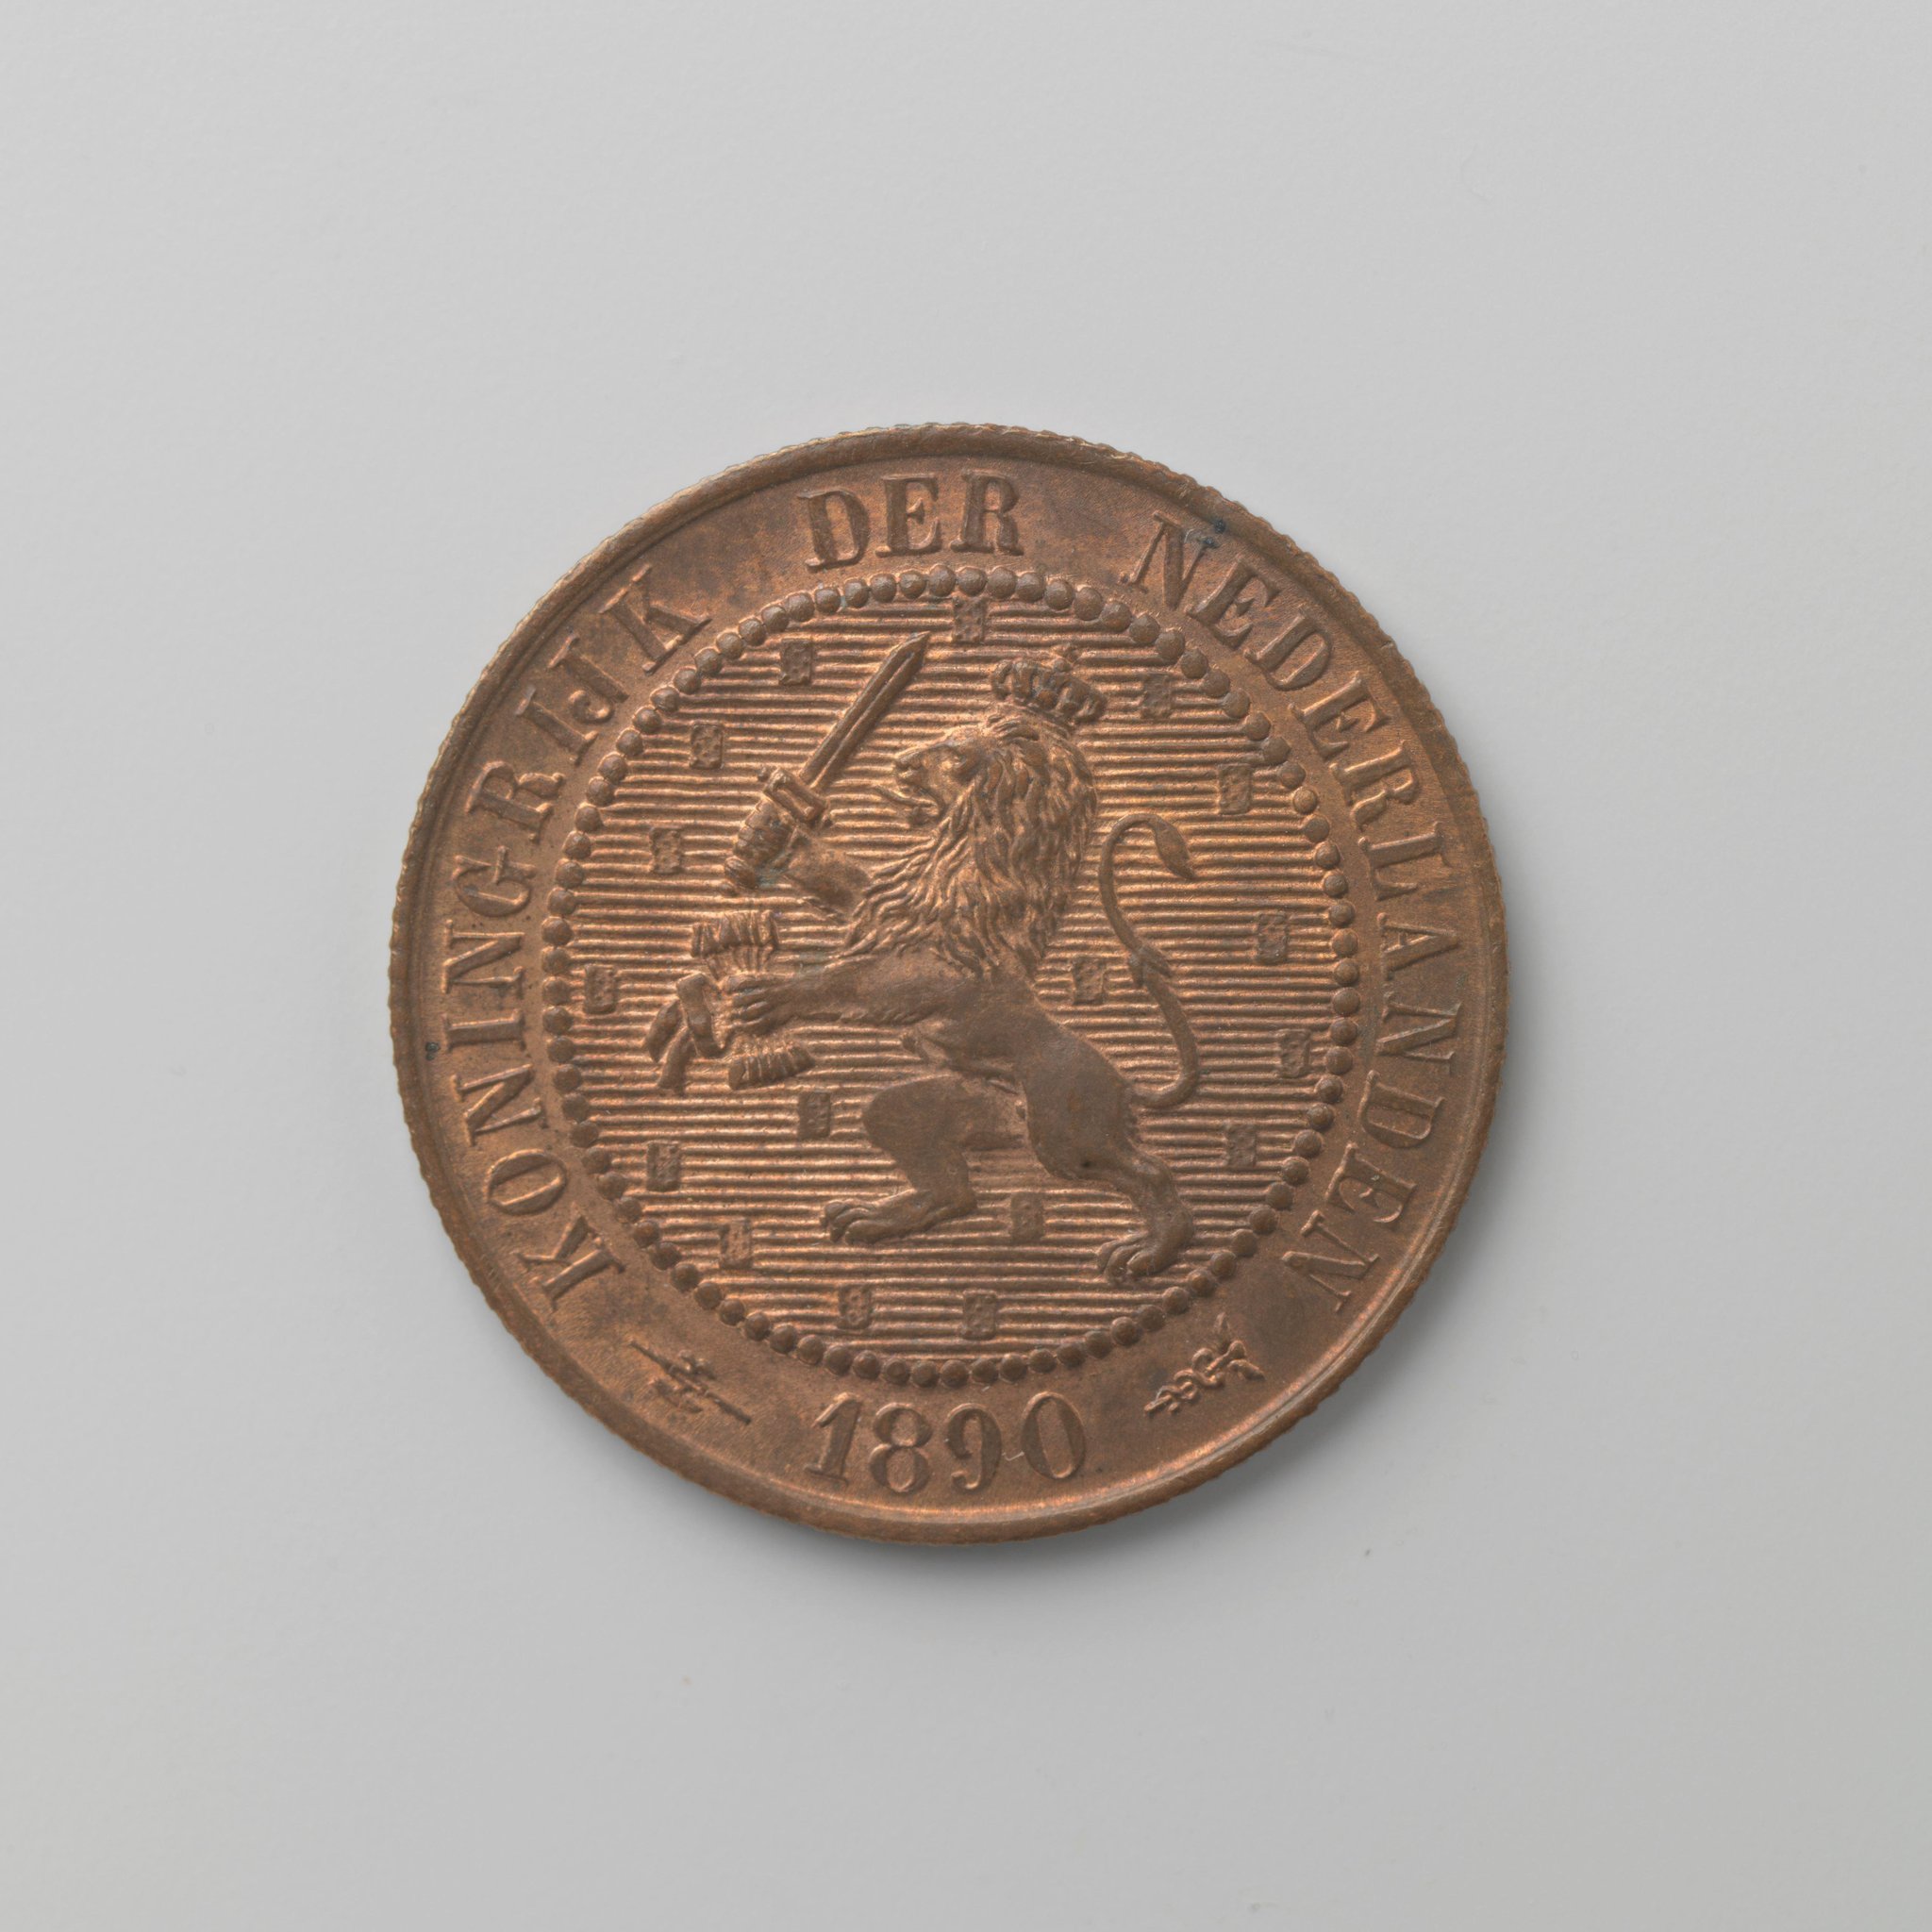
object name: coin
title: Nederland, 2½ cent, 1890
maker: willem iii (koning der nederlanden)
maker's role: koning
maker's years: 1817-1890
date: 1890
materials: bronze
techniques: striking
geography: utrecht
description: Bronzen munt. Voorzijde: in een veld rijkswapen. Jaartal onderaan in omschrift. Keerzijde: binnen twee samengebonden oranjetakken waarde-aanduiding 2½ cent. Kartelrand.